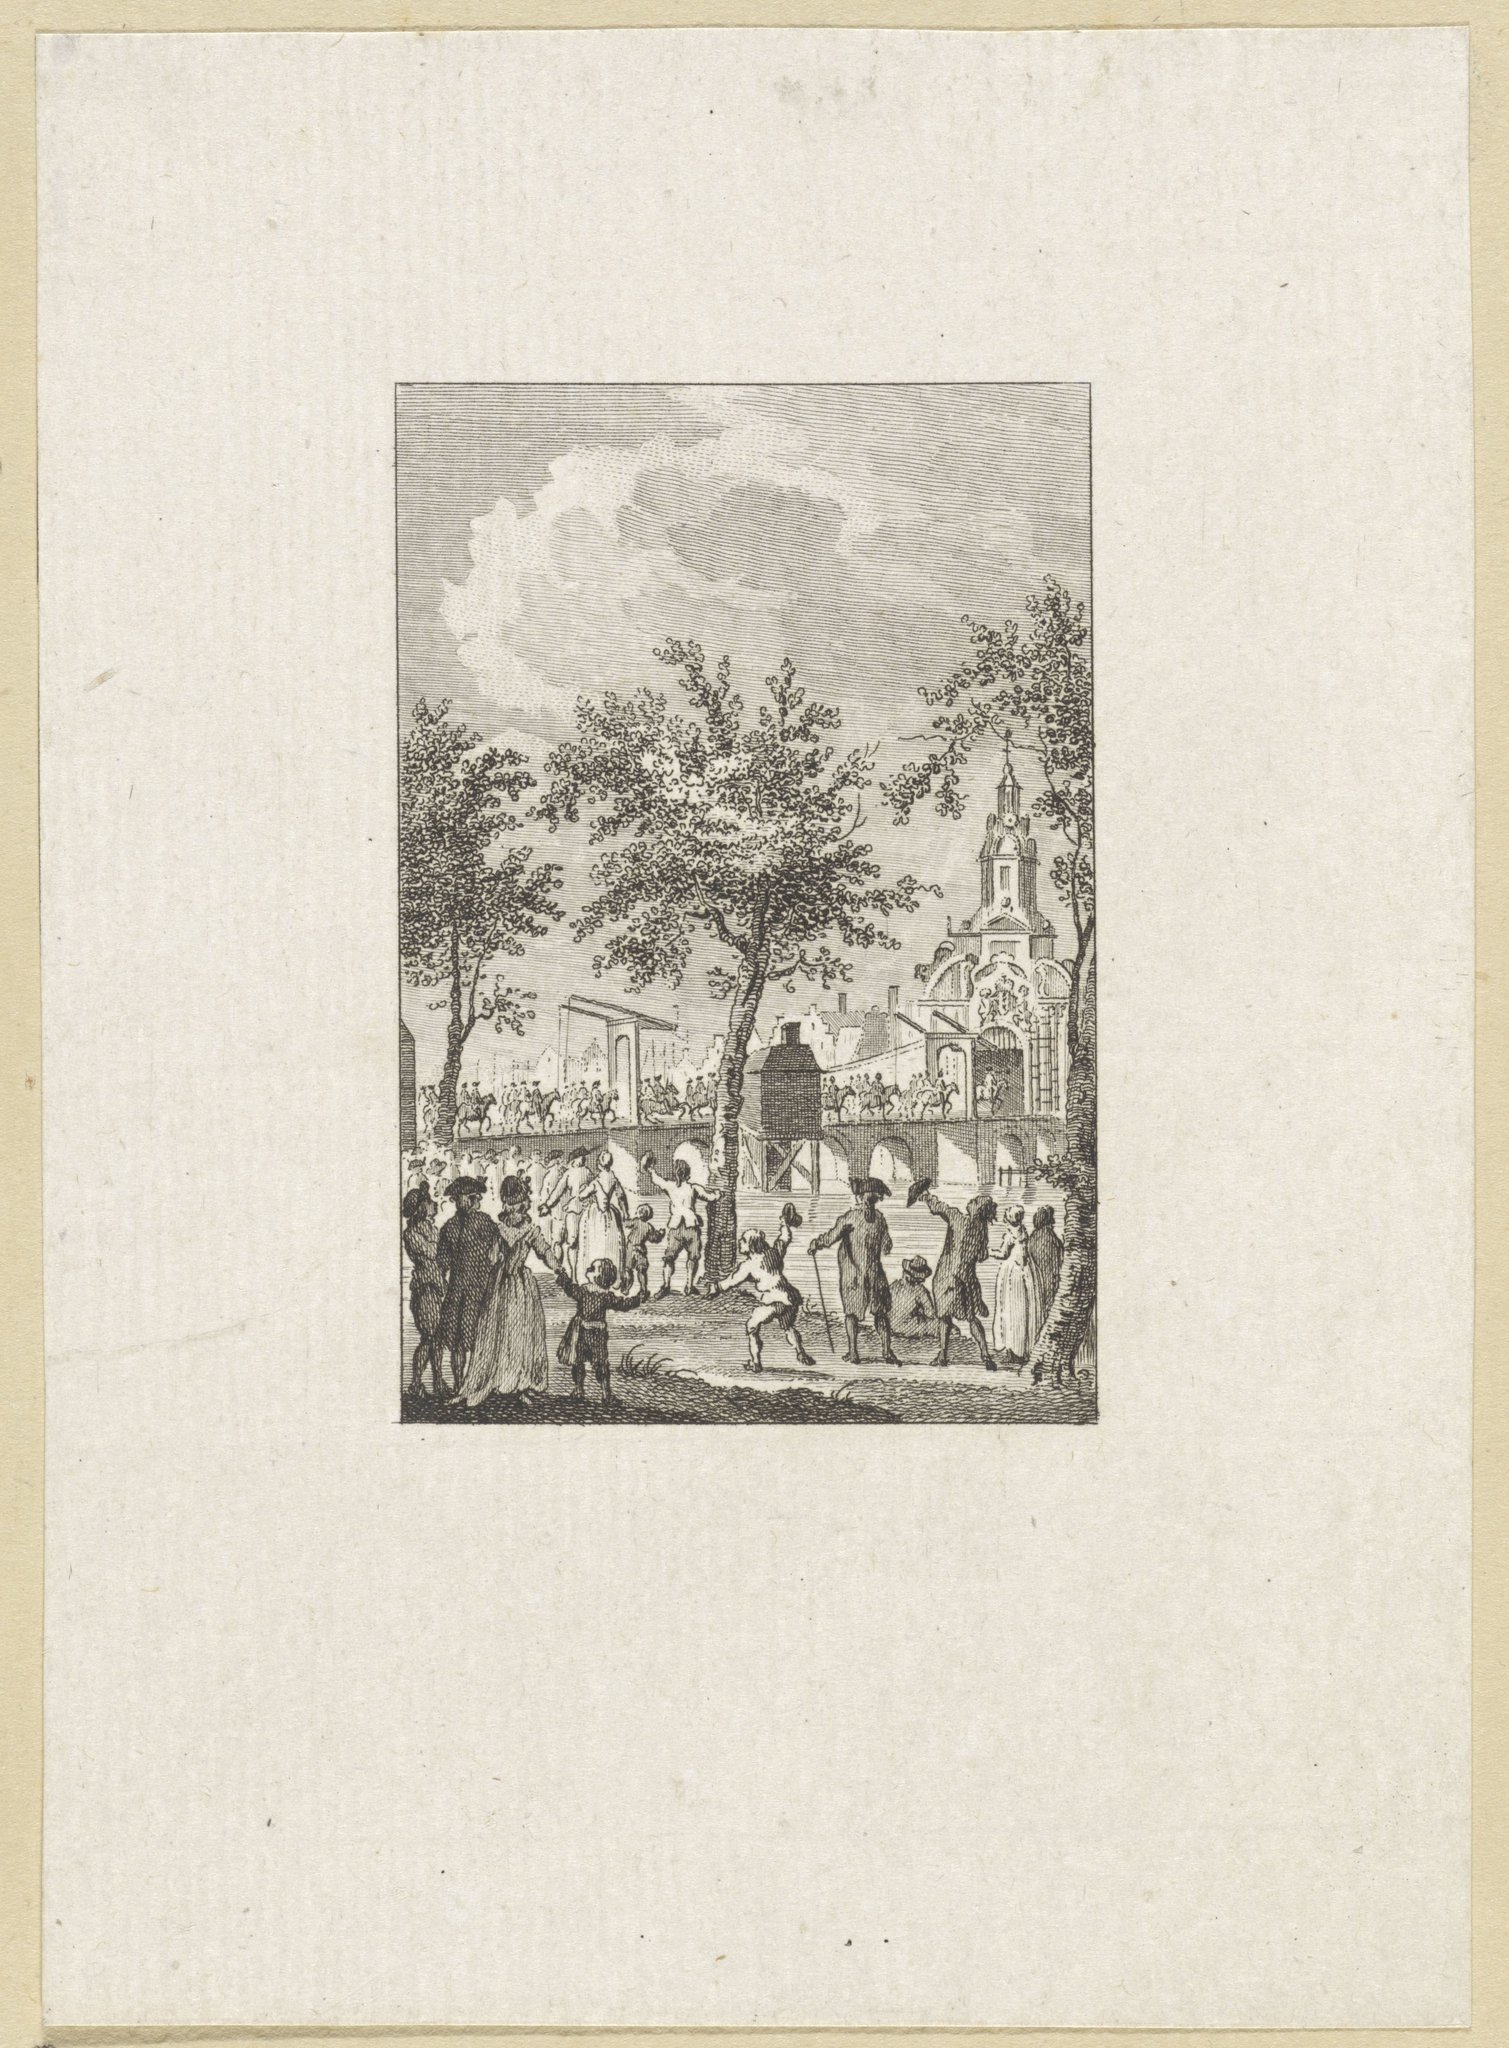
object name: history print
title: Intocht van de Hollandse Gardes te Amsterdam, 1787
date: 1783-1795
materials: paper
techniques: etching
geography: amsterdam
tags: march into the conquered place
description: Illustratie voor: J. Fokke. Geschiedenissen der Vereenigde Nederlanden voor de vaderlandsche jeugd. Amsterdam: Johannes Allart, 1783-1795, 25 delen. deel XX pl. V.